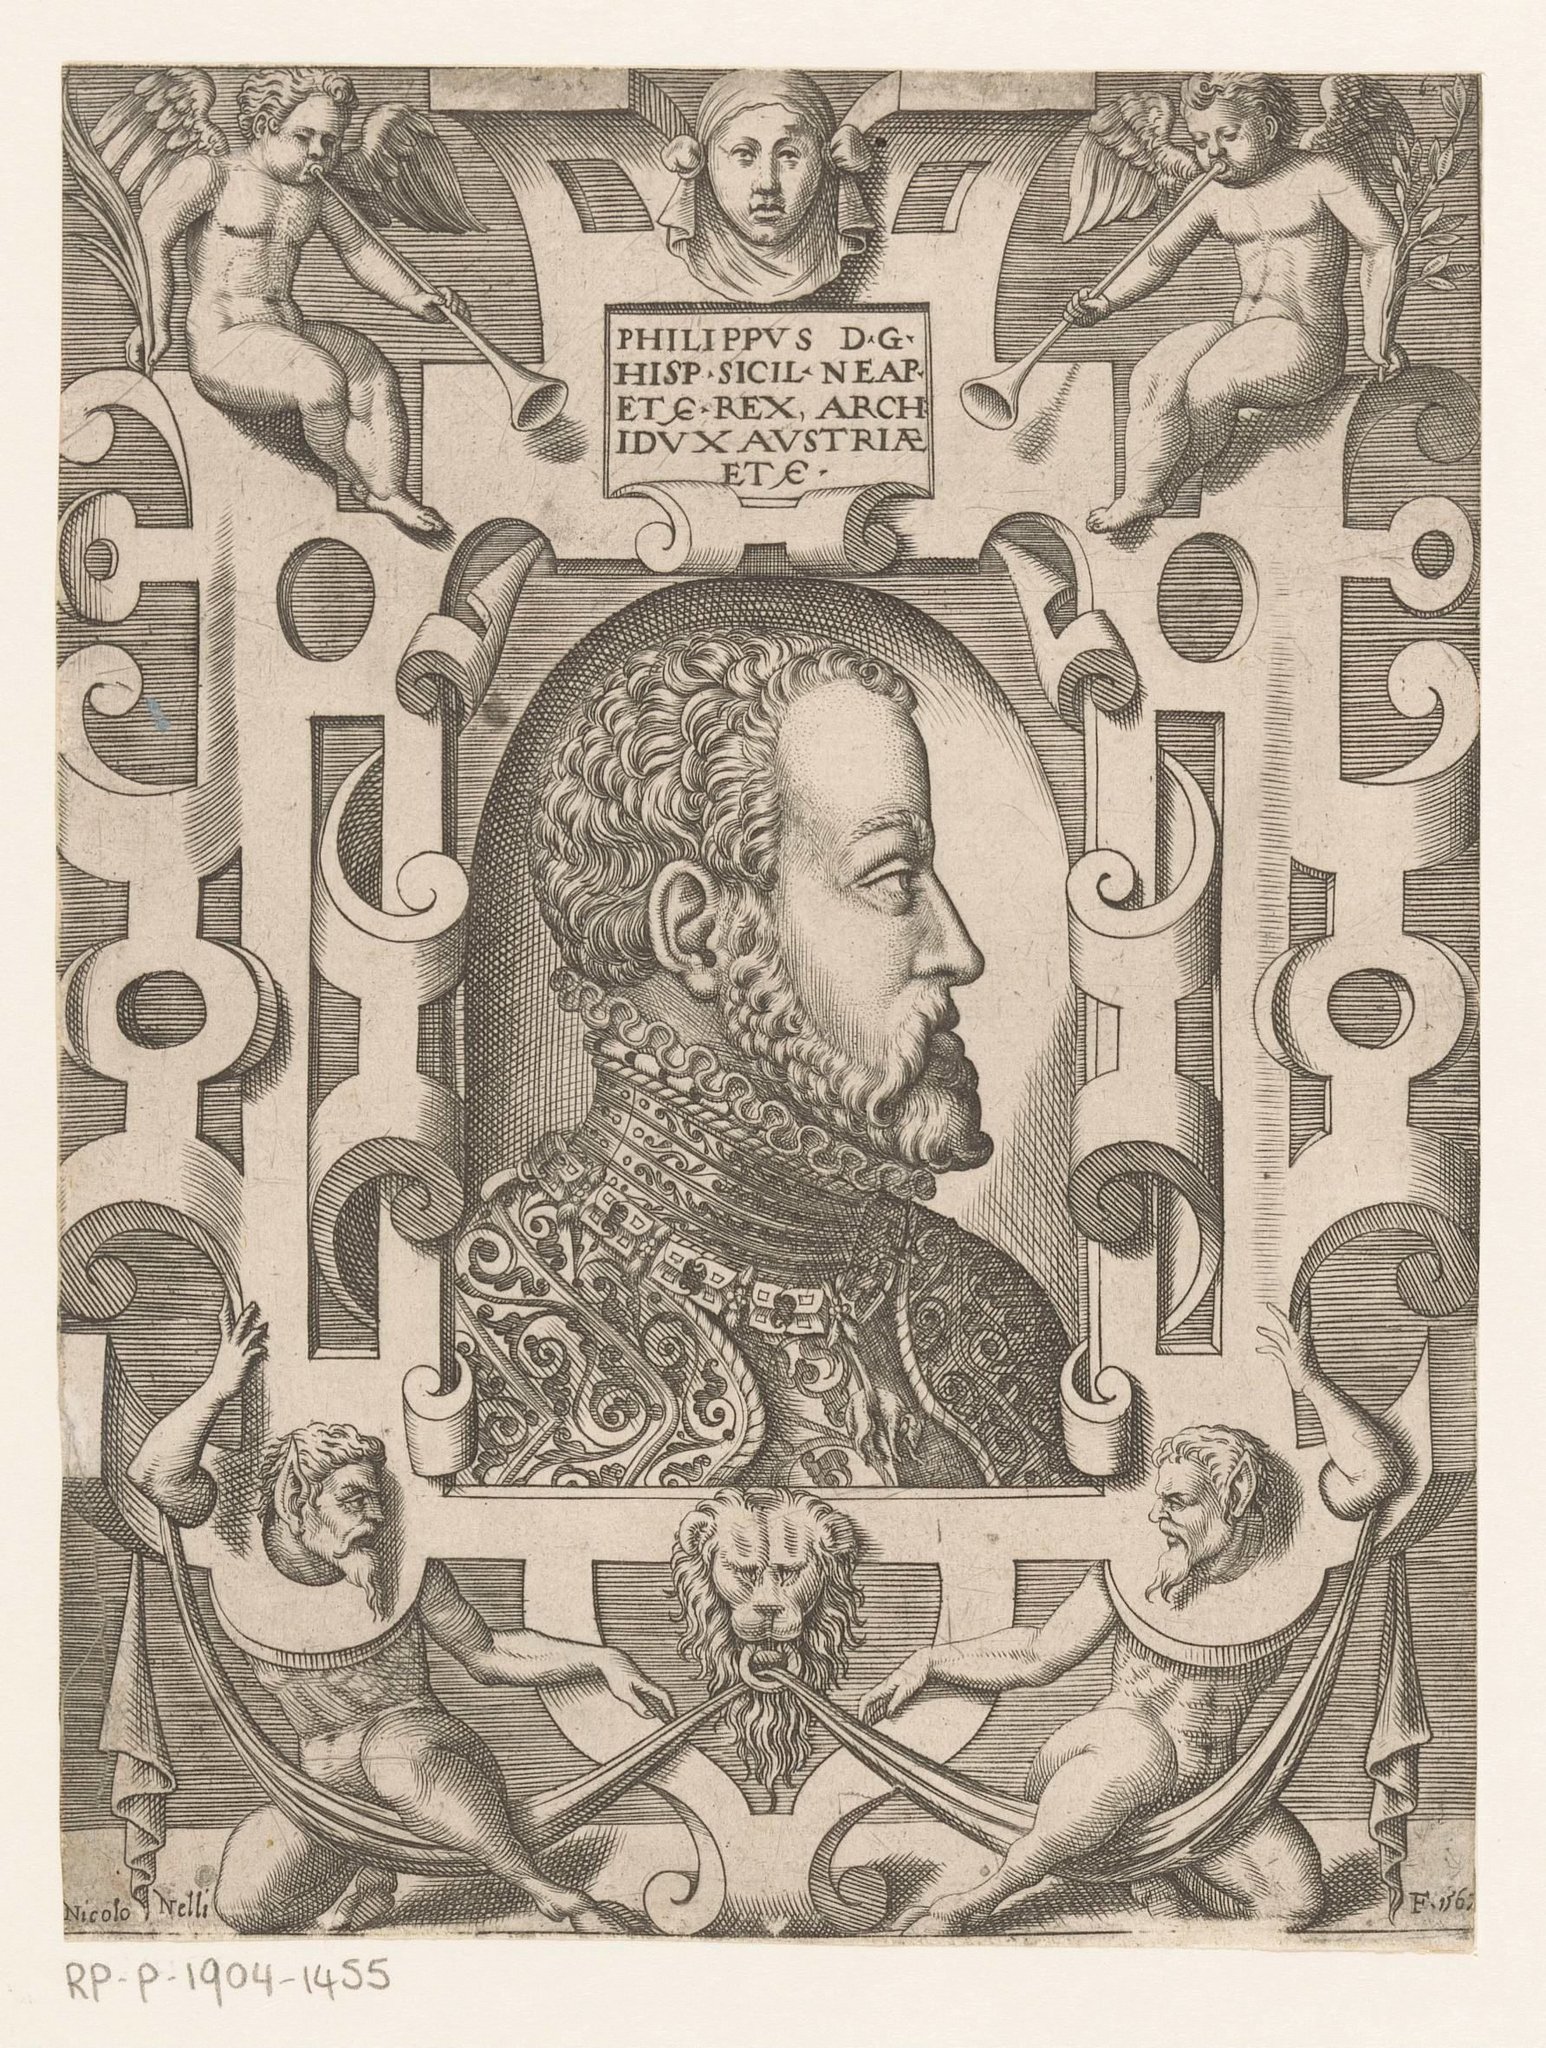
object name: print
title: Portret van Filips II, koning van Spanje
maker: niccolò nelli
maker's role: print maker, publisher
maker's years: 1535-1585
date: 1567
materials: paper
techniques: engraving, etching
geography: venice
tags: philip ii of spain, angels singing, making music, ornament ~ hybrid beings; human and animal forms mixed - aa - stylized, historical persons, satyr(s) (in general), ruler, sovereign, knighthood order of the golden fleece - insignia of a knighthood order, e.g.: badge, chain (with name of order), ornament derived from architectural details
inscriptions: collector's mark: Lugt 2228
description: Prent mogelijk gebruikt voor een serie portretten van onbekende omvang getiteld 'Imagines Quorundam Principum et Illustrium Virorum' met prenten door Niccolò Nelli, Domenico Zenoi, Martino Rota, Nicolas Bèatrizet en Cornelis Cort, uitgegeven in 1569 te Venetië.